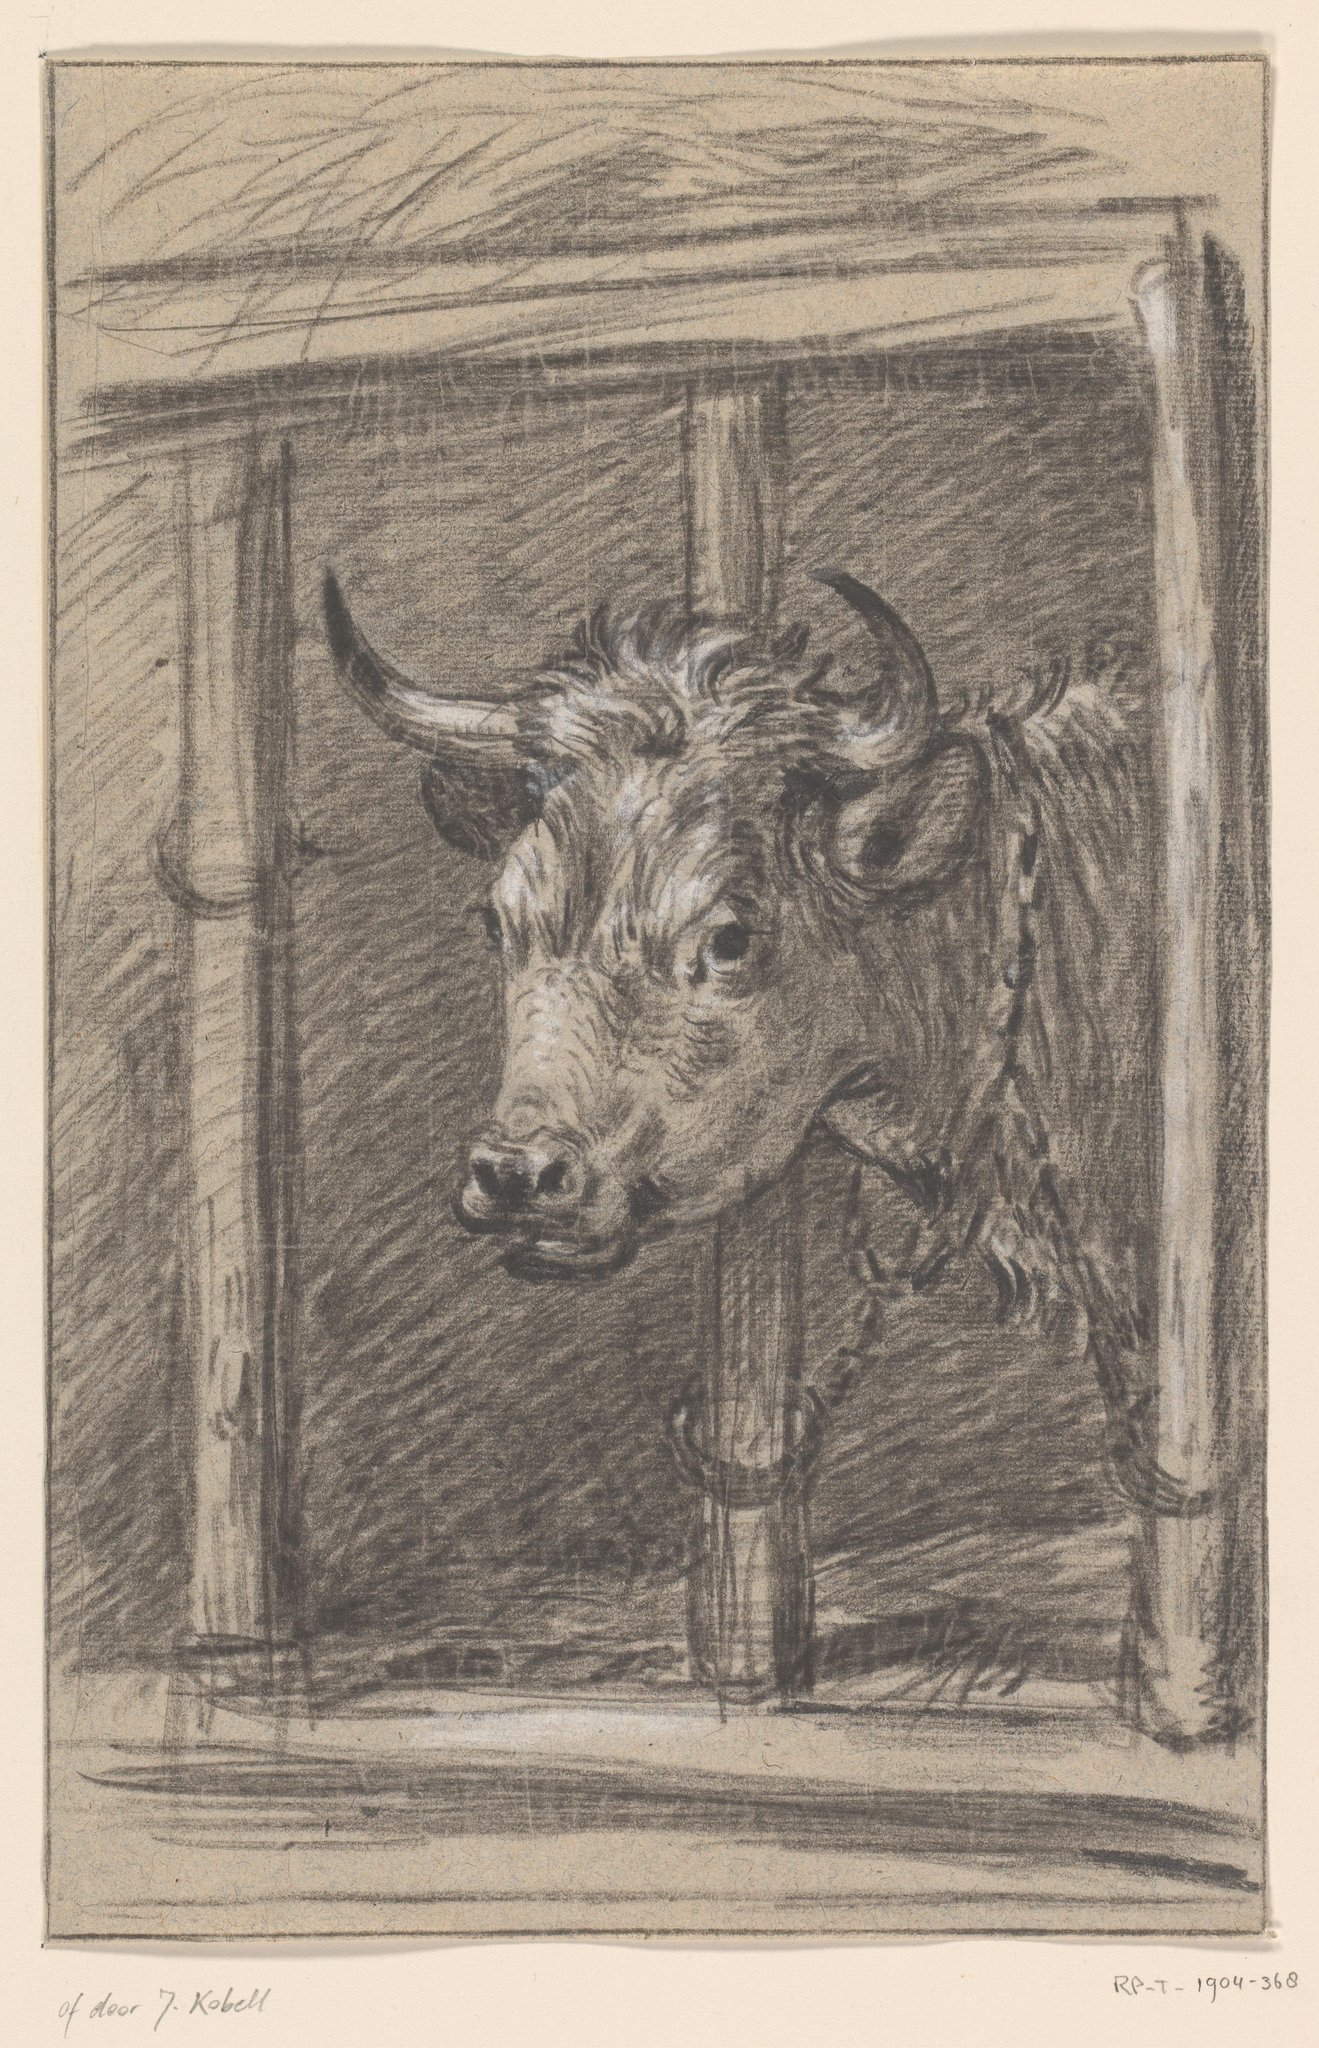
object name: drawing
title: Kop van een koe, door de spijlen van een stal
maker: jean bernard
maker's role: draughtsman, print maker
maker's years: 1765-1833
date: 1775-1833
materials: chalk, paper, pencil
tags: cow